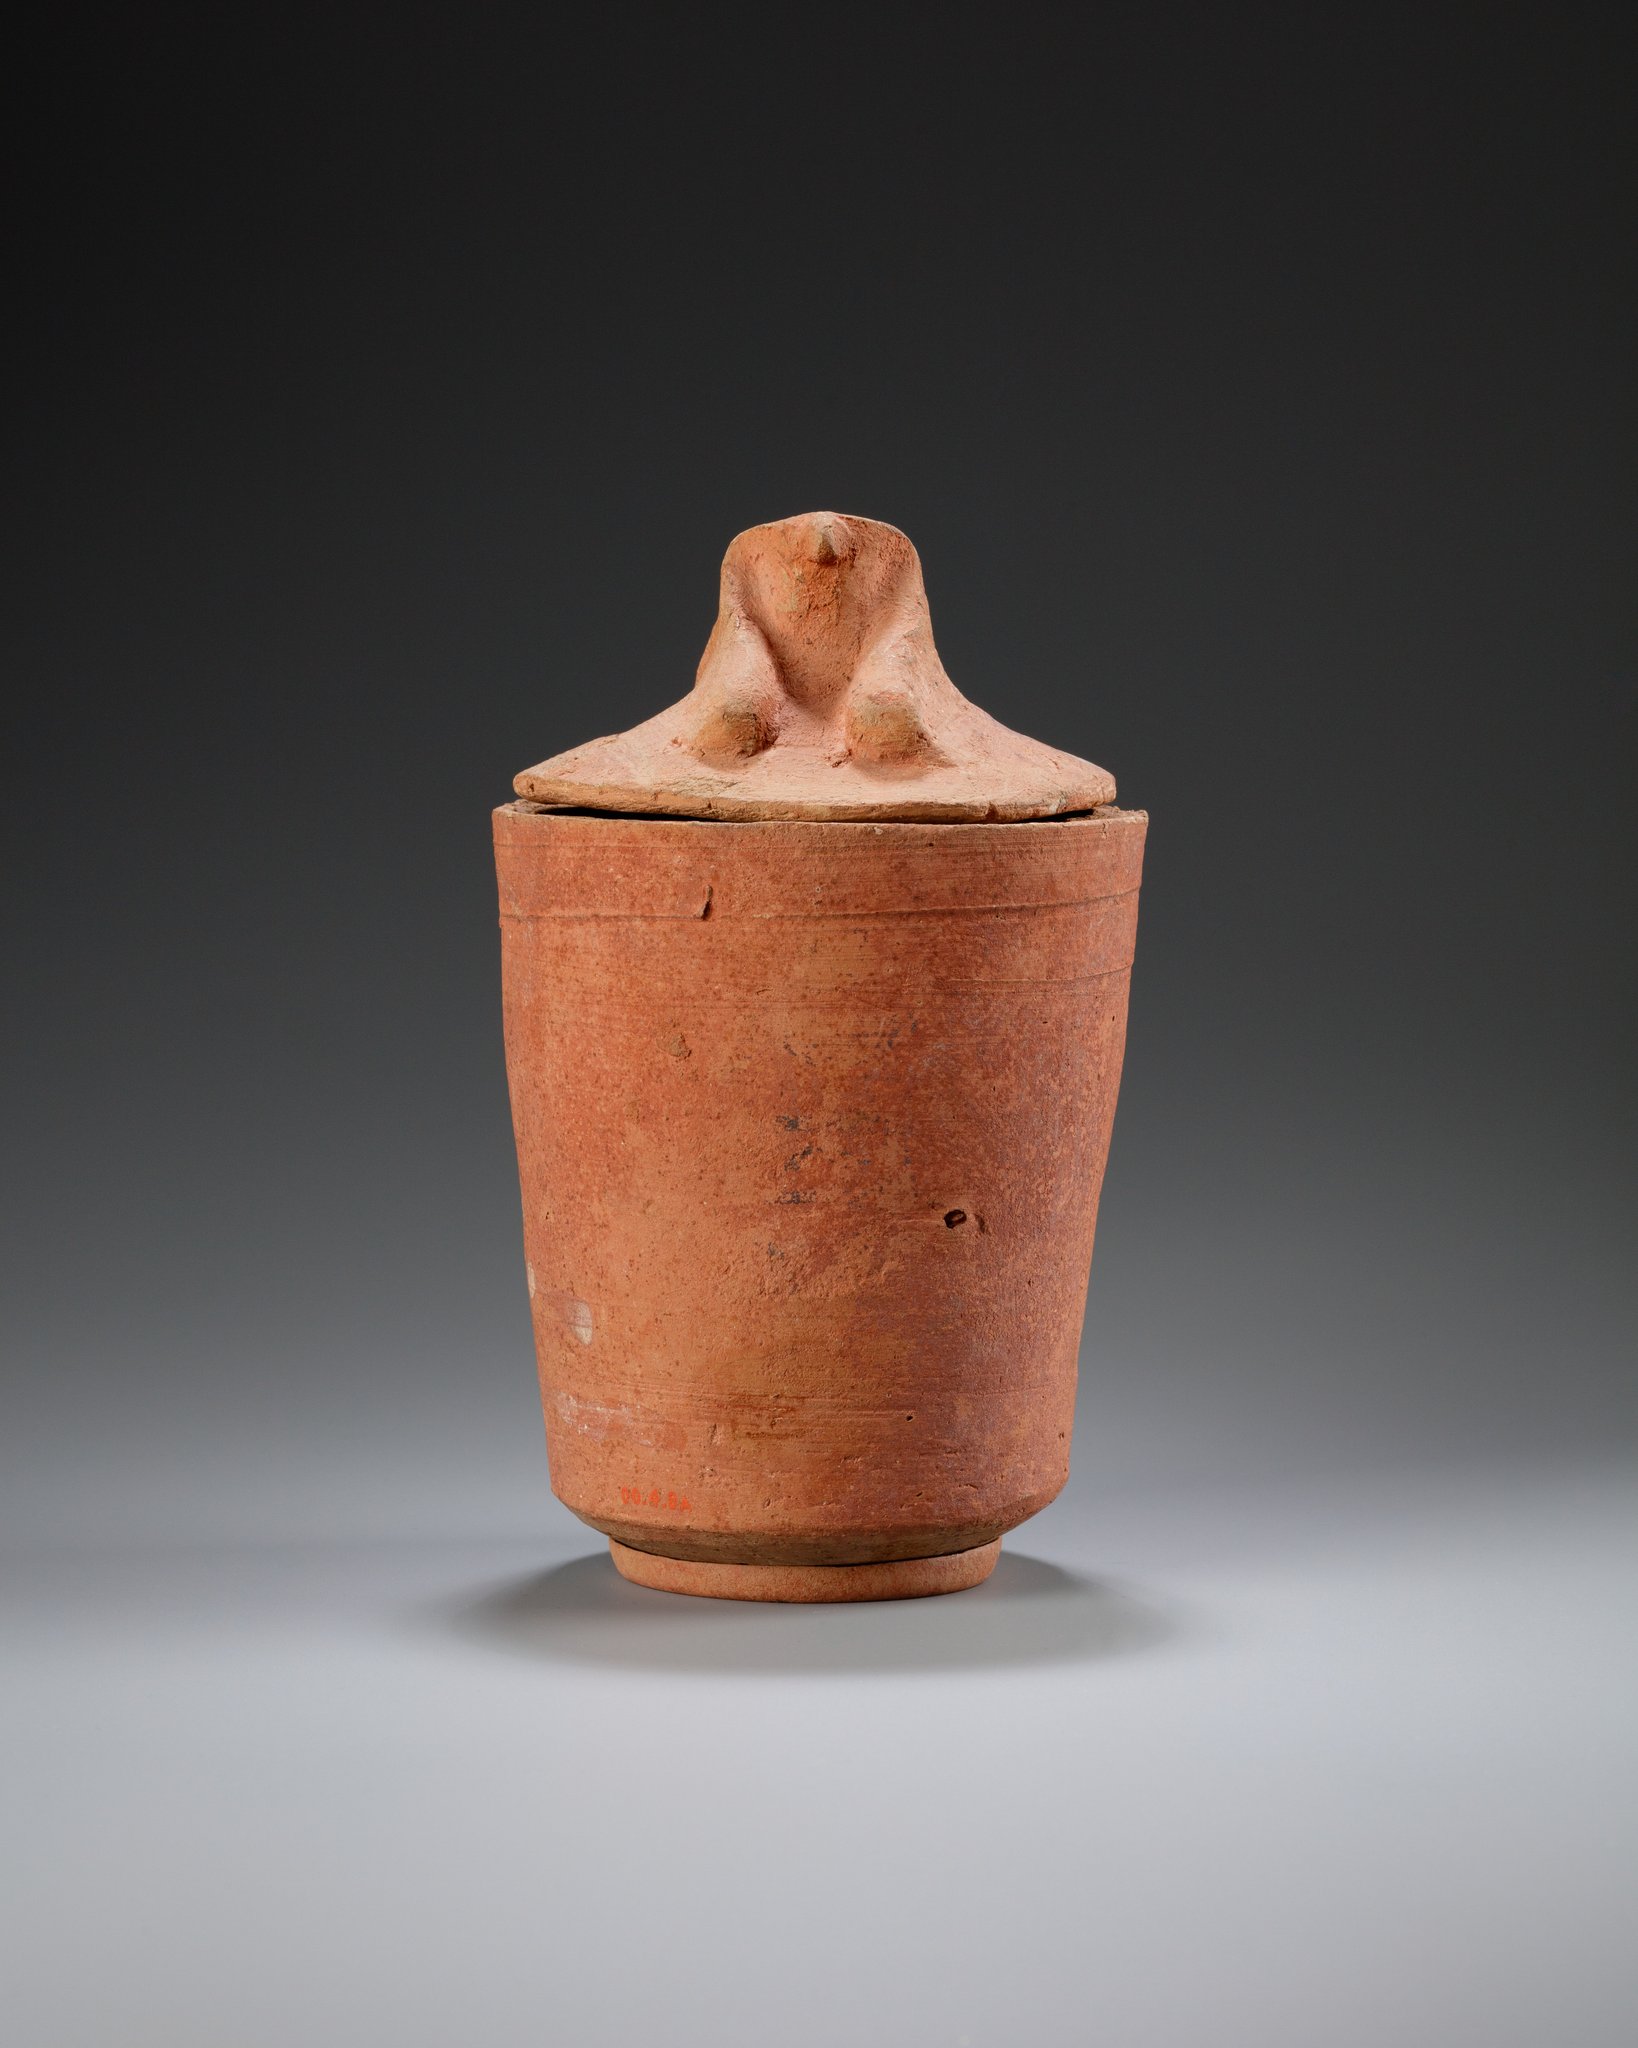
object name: canopic jar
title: Canopic jar with falcon head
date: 664-332 BCE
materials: paint, pottery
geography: egypt